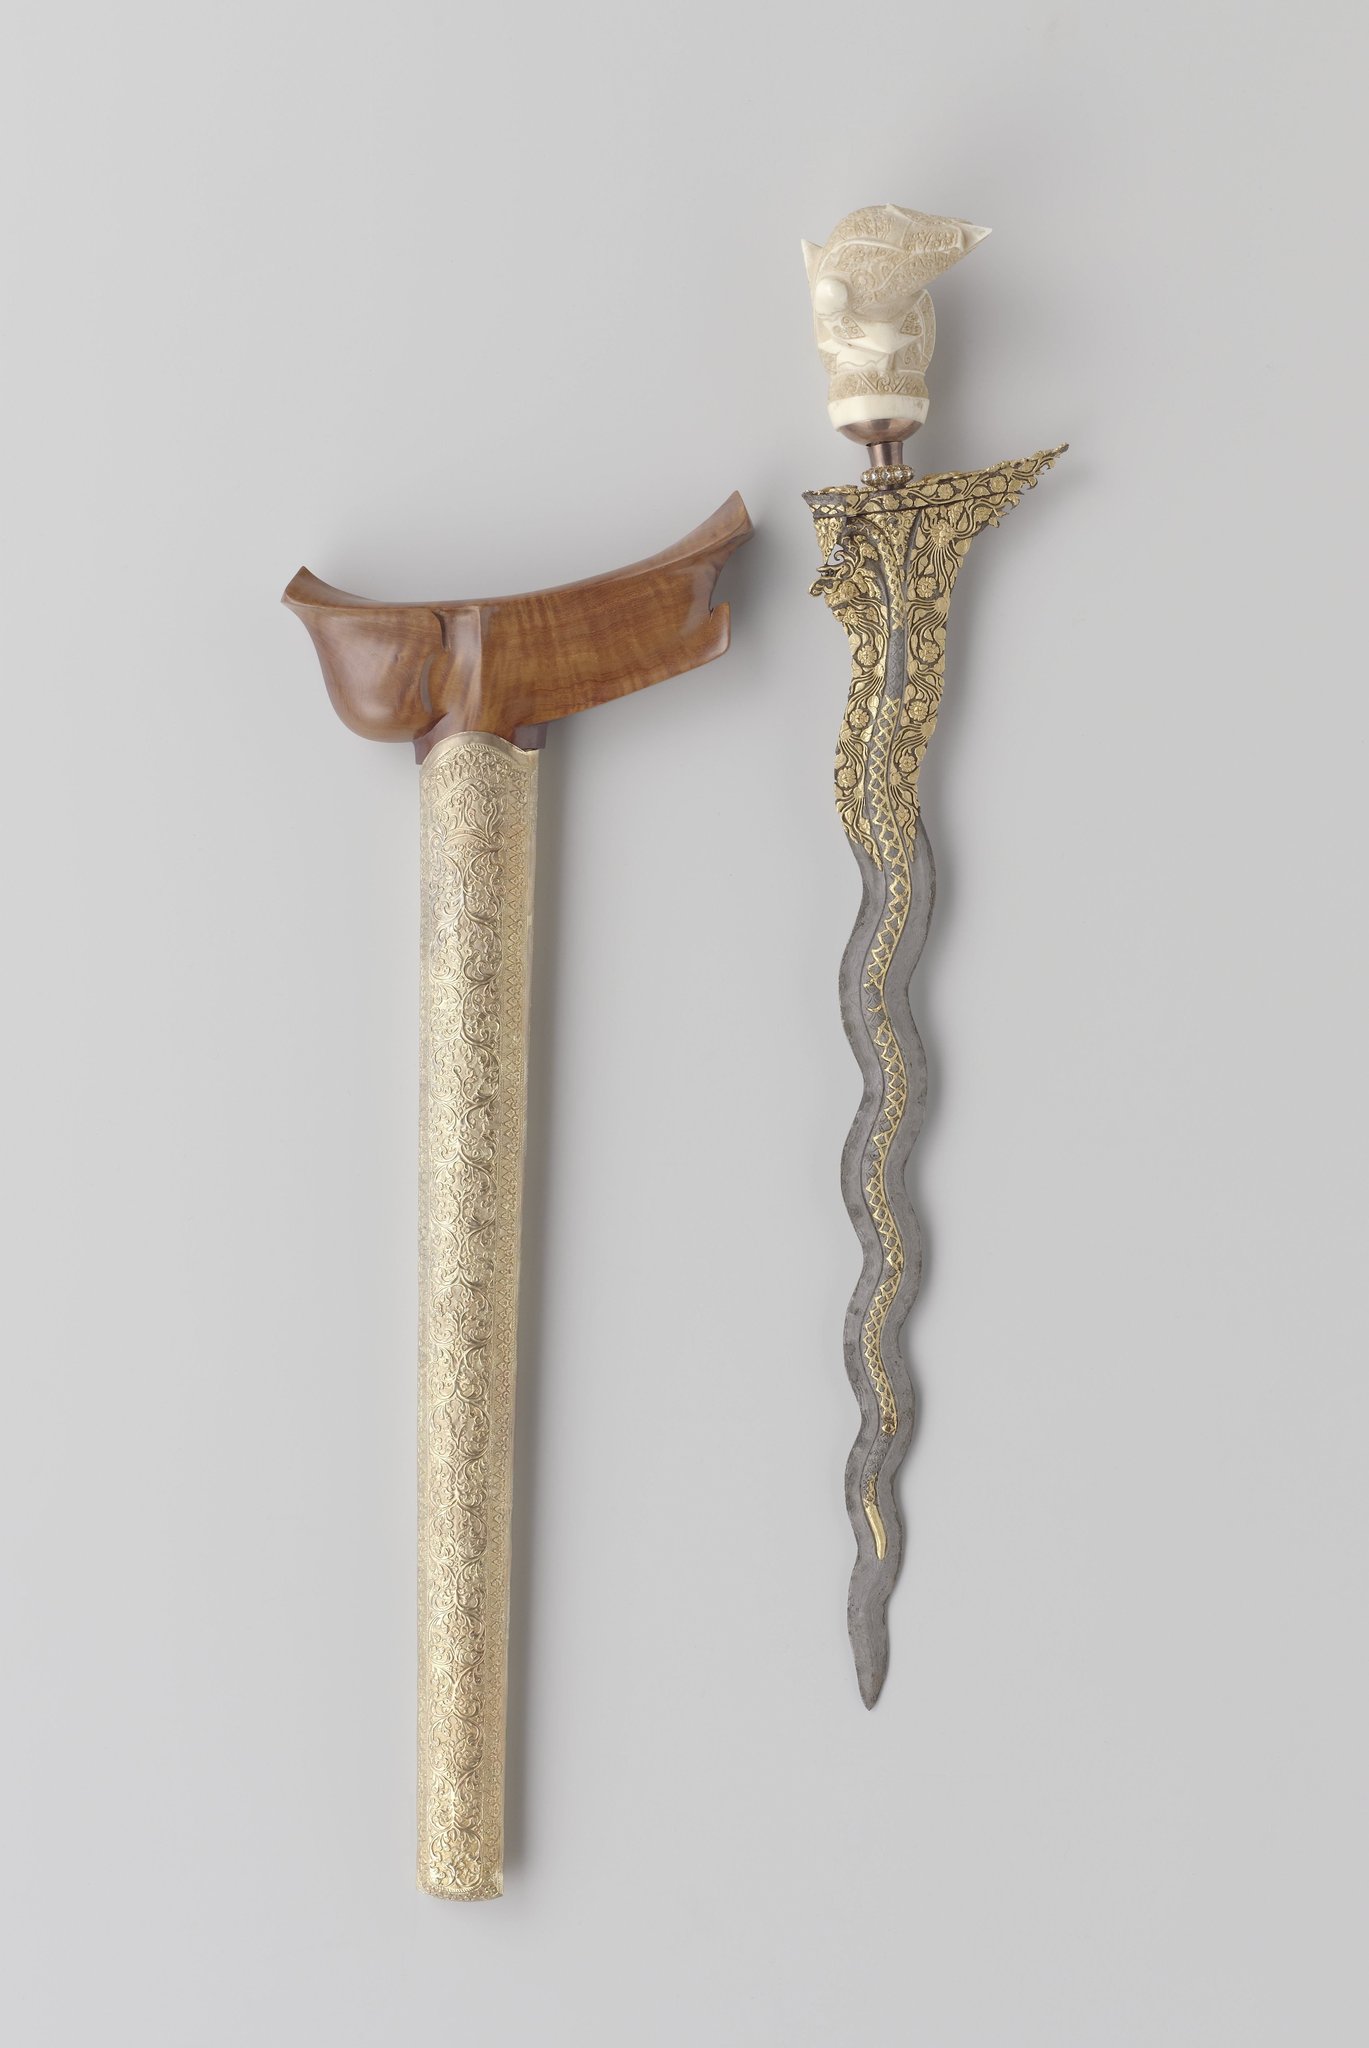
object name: kris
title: Kris of a high-ranking dignitary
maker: Anonymous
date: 1600-1700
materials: diamond, gold, iron, ivory, nickel, wood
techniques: pamo technique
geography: palembang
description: The wavy or ‘flaming’ blade of this kris comes from Java. It was later fitted with a hilt and a sheath in the sultanate of Palembang on Sumatra, where there was an important kris workshop. The luxurious finish suggests that the kris belonged to a high-ranking dignitary. The small ring between the hilt and blade (mendak), for example, is inlaid with diamonds. The hilt is in the form of a bird’s head.